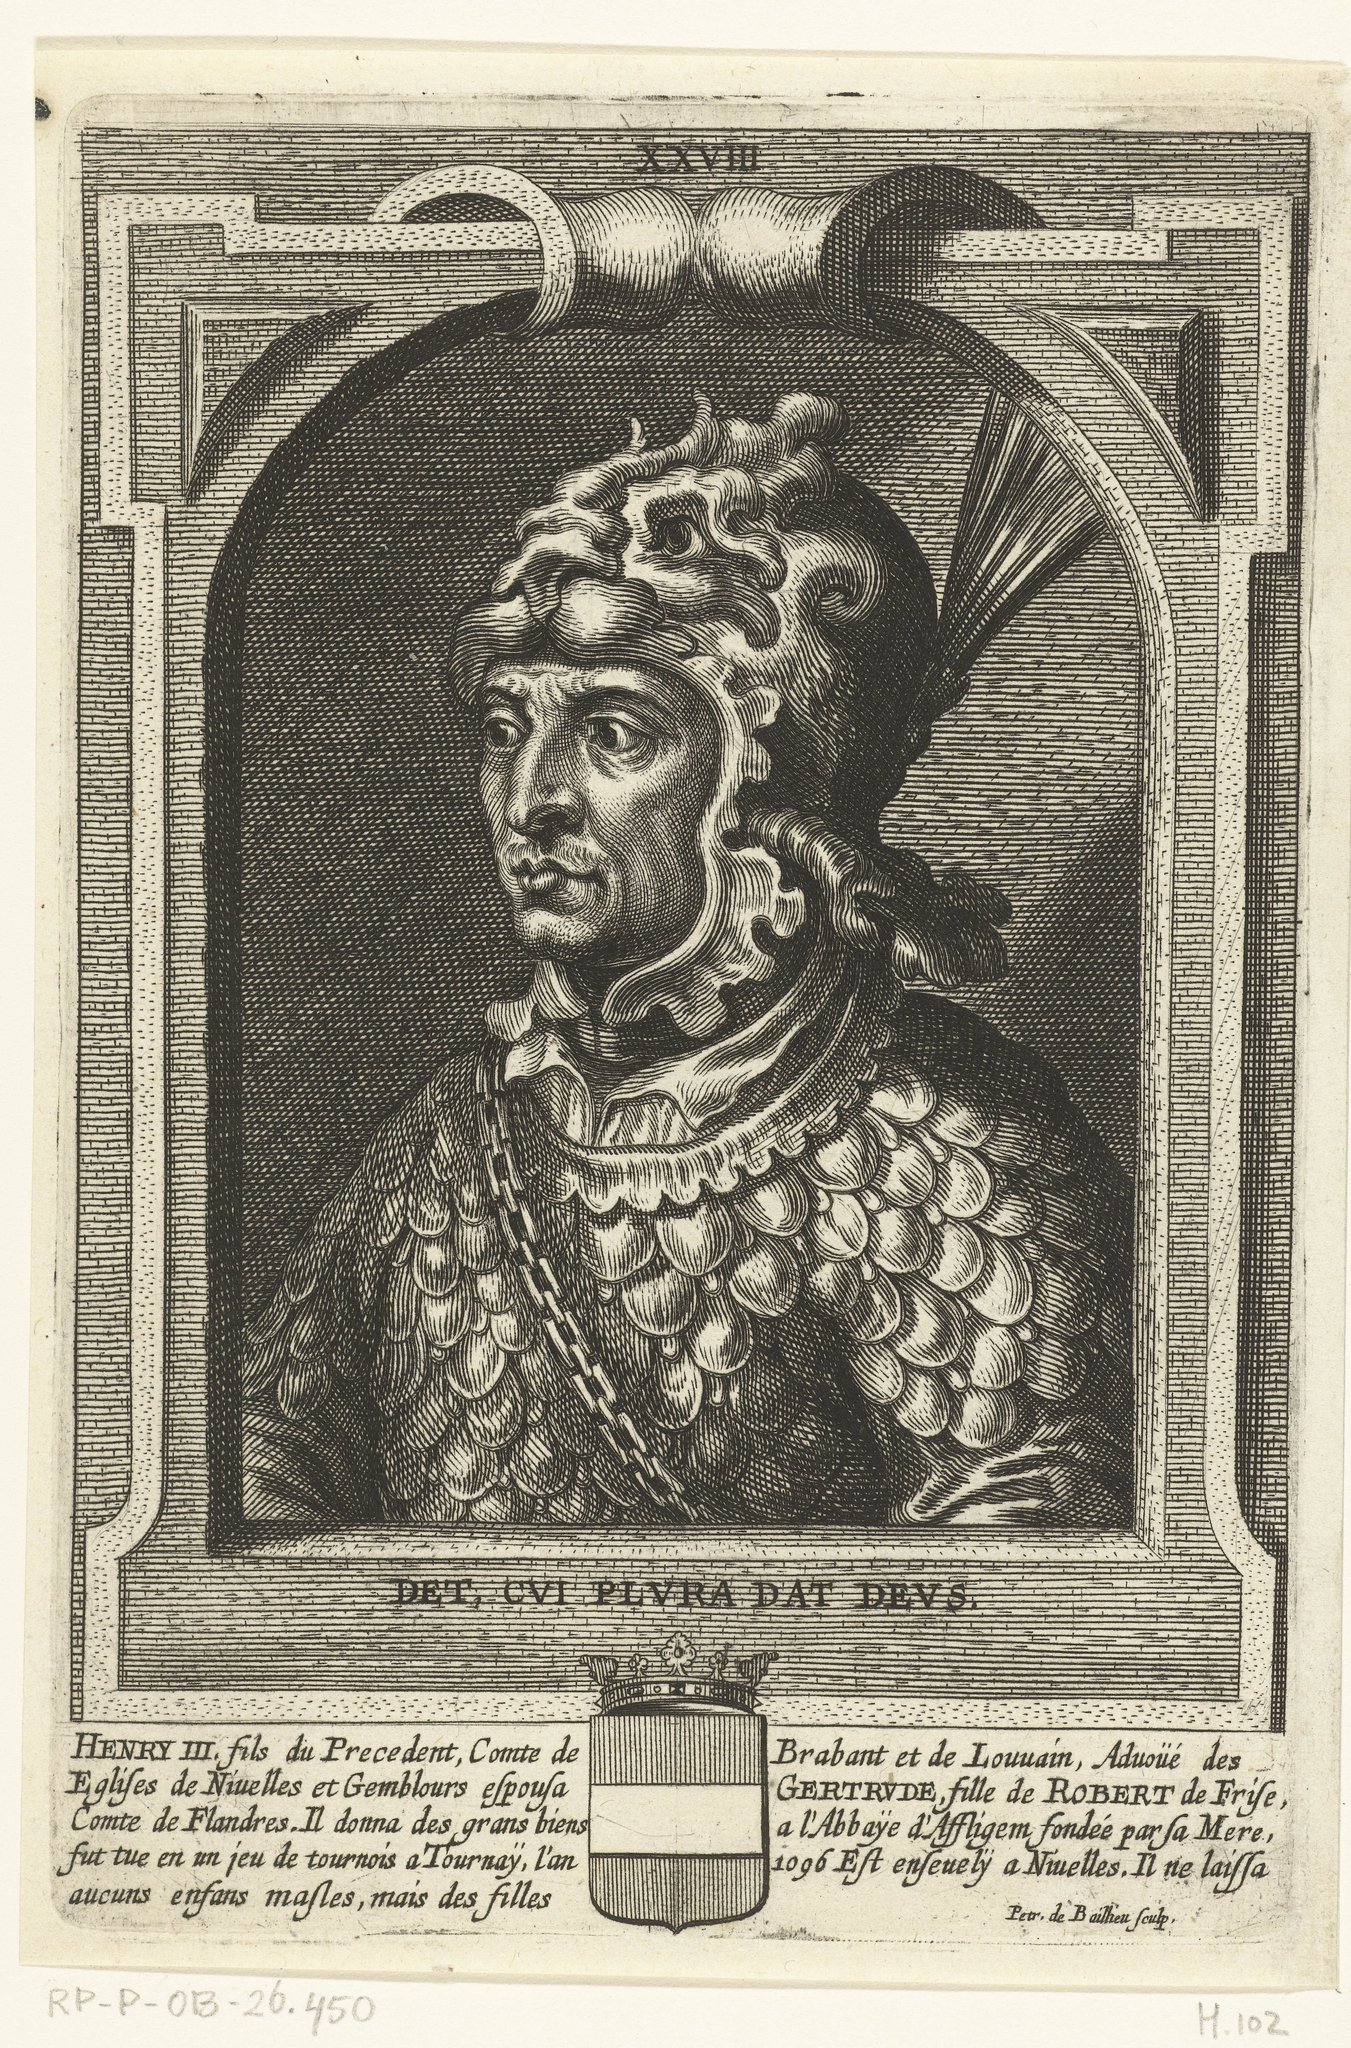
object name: print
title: Henry III fils (...) mais des filles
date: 1623-1660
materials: paper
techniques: engraving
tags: hendrik iii van leuven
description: Prent gebruikt voor: Les Effigies des Souverains princes et Ducs de Brabant. Joannes Meyssens (uitgever), Antwerpen 1661. De publicatie bevat vierenvijftig portretten waarvan zes door Pieter de Bailliu.